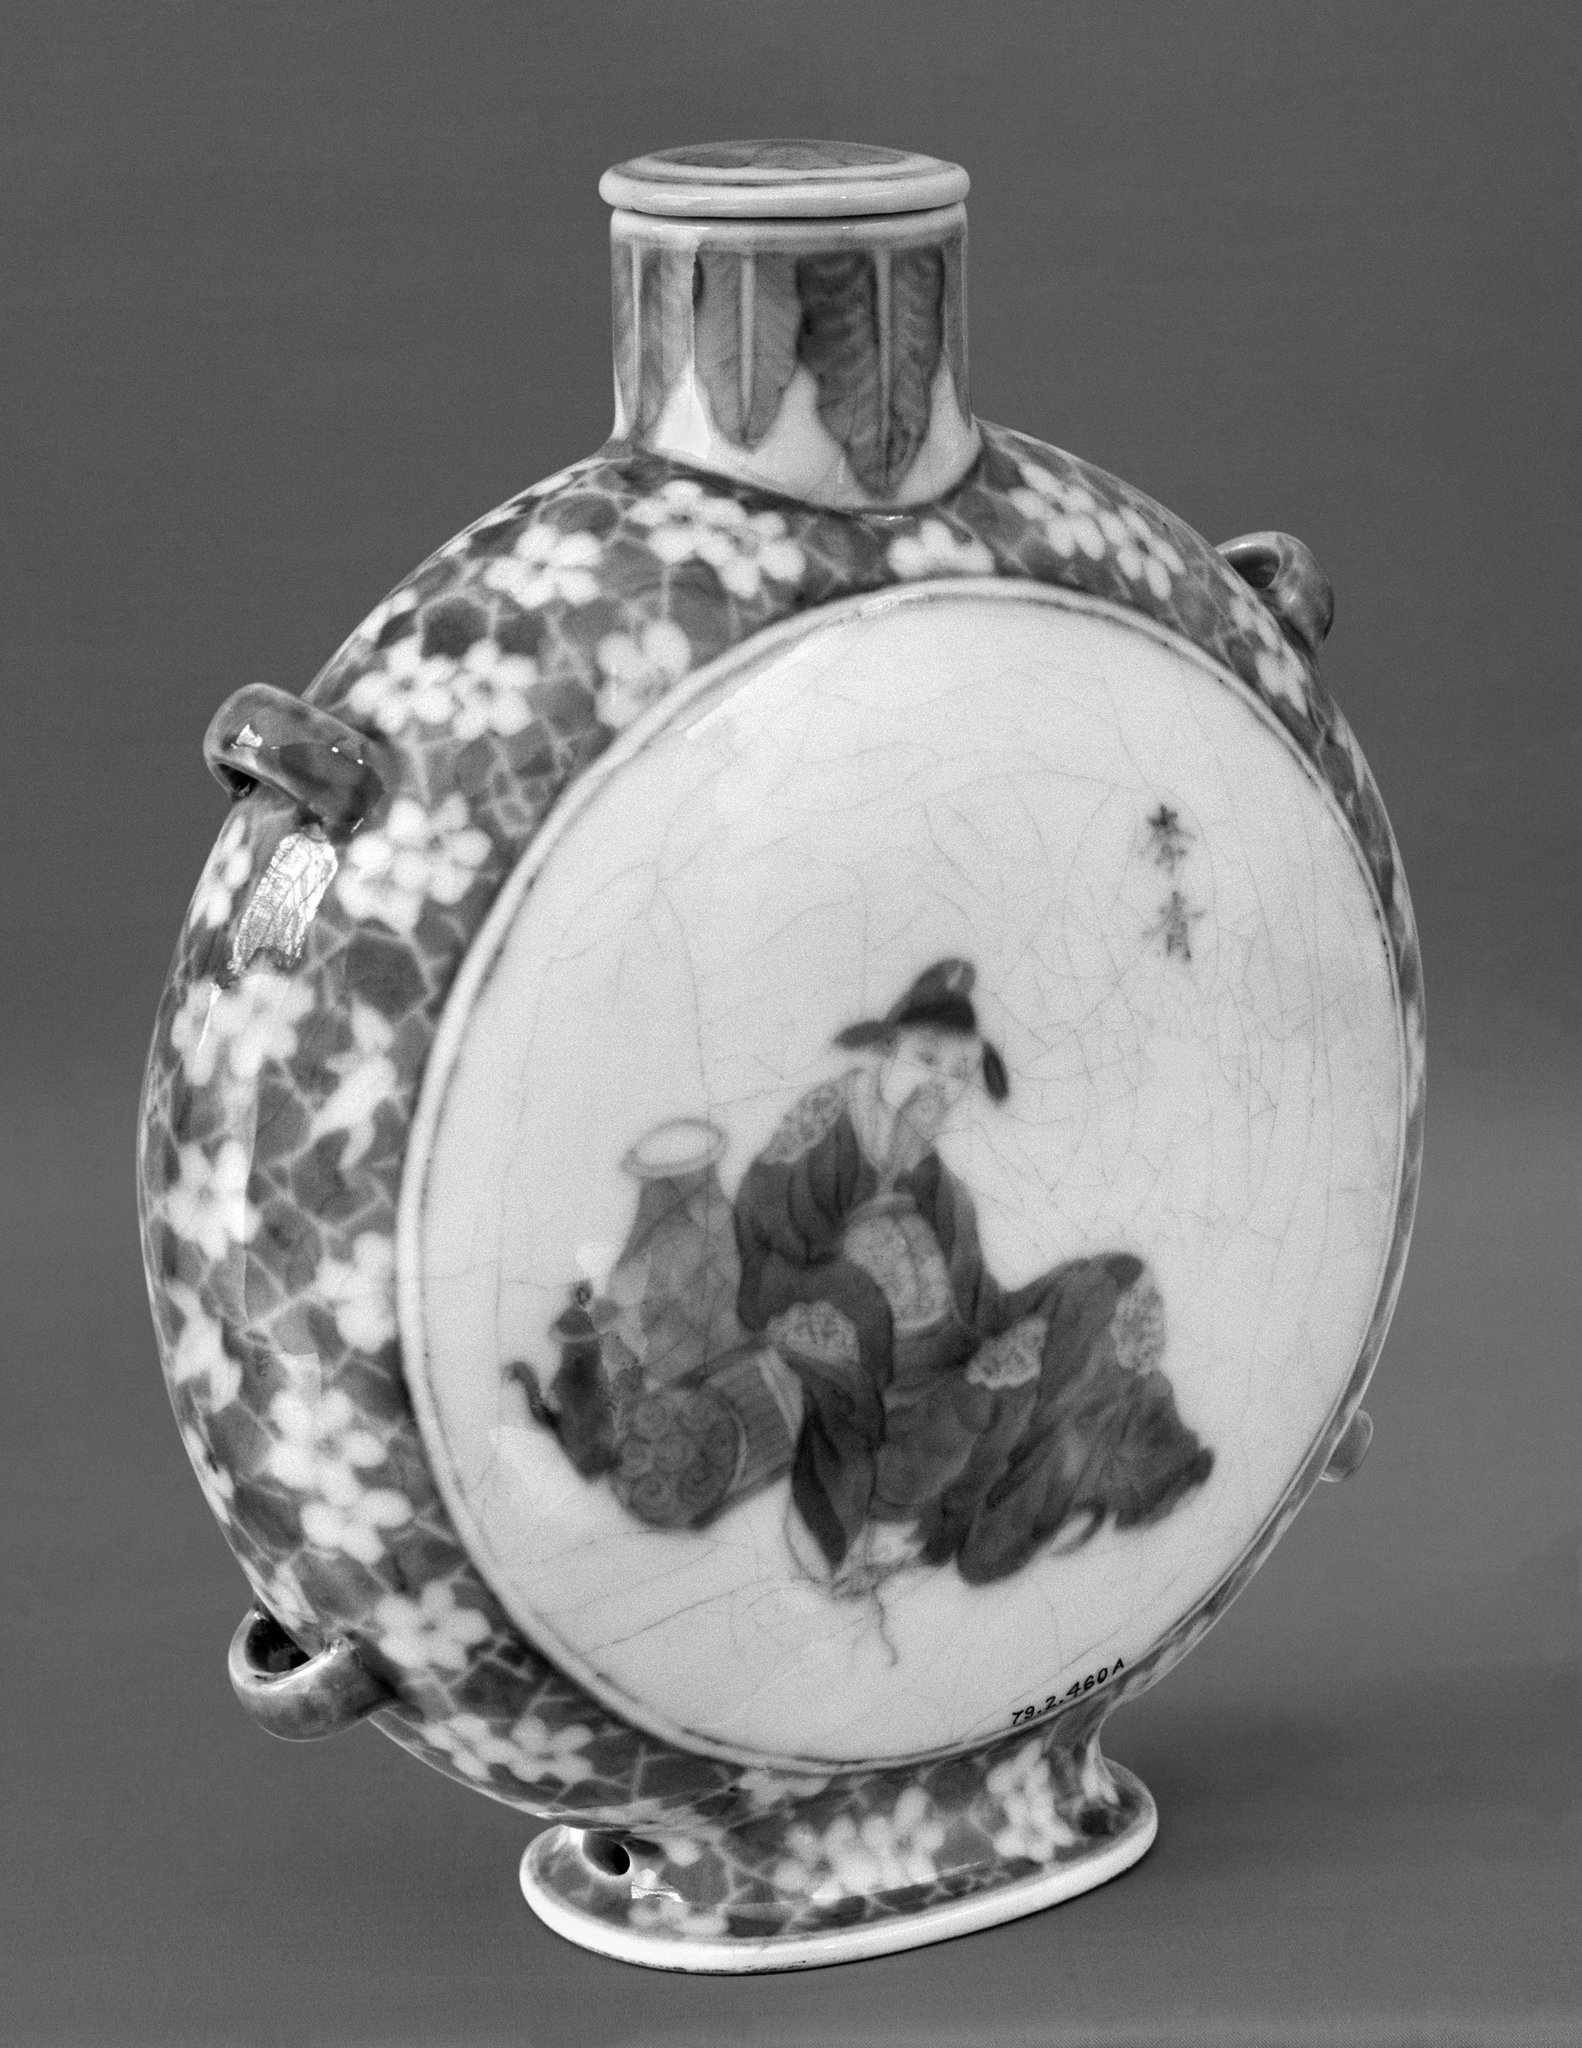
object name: covered flask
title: Covered flask with poet Li Bai and landscape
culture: chinese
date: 1801-1900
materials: cobalt, porcelain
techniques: painting, underglaze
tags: men